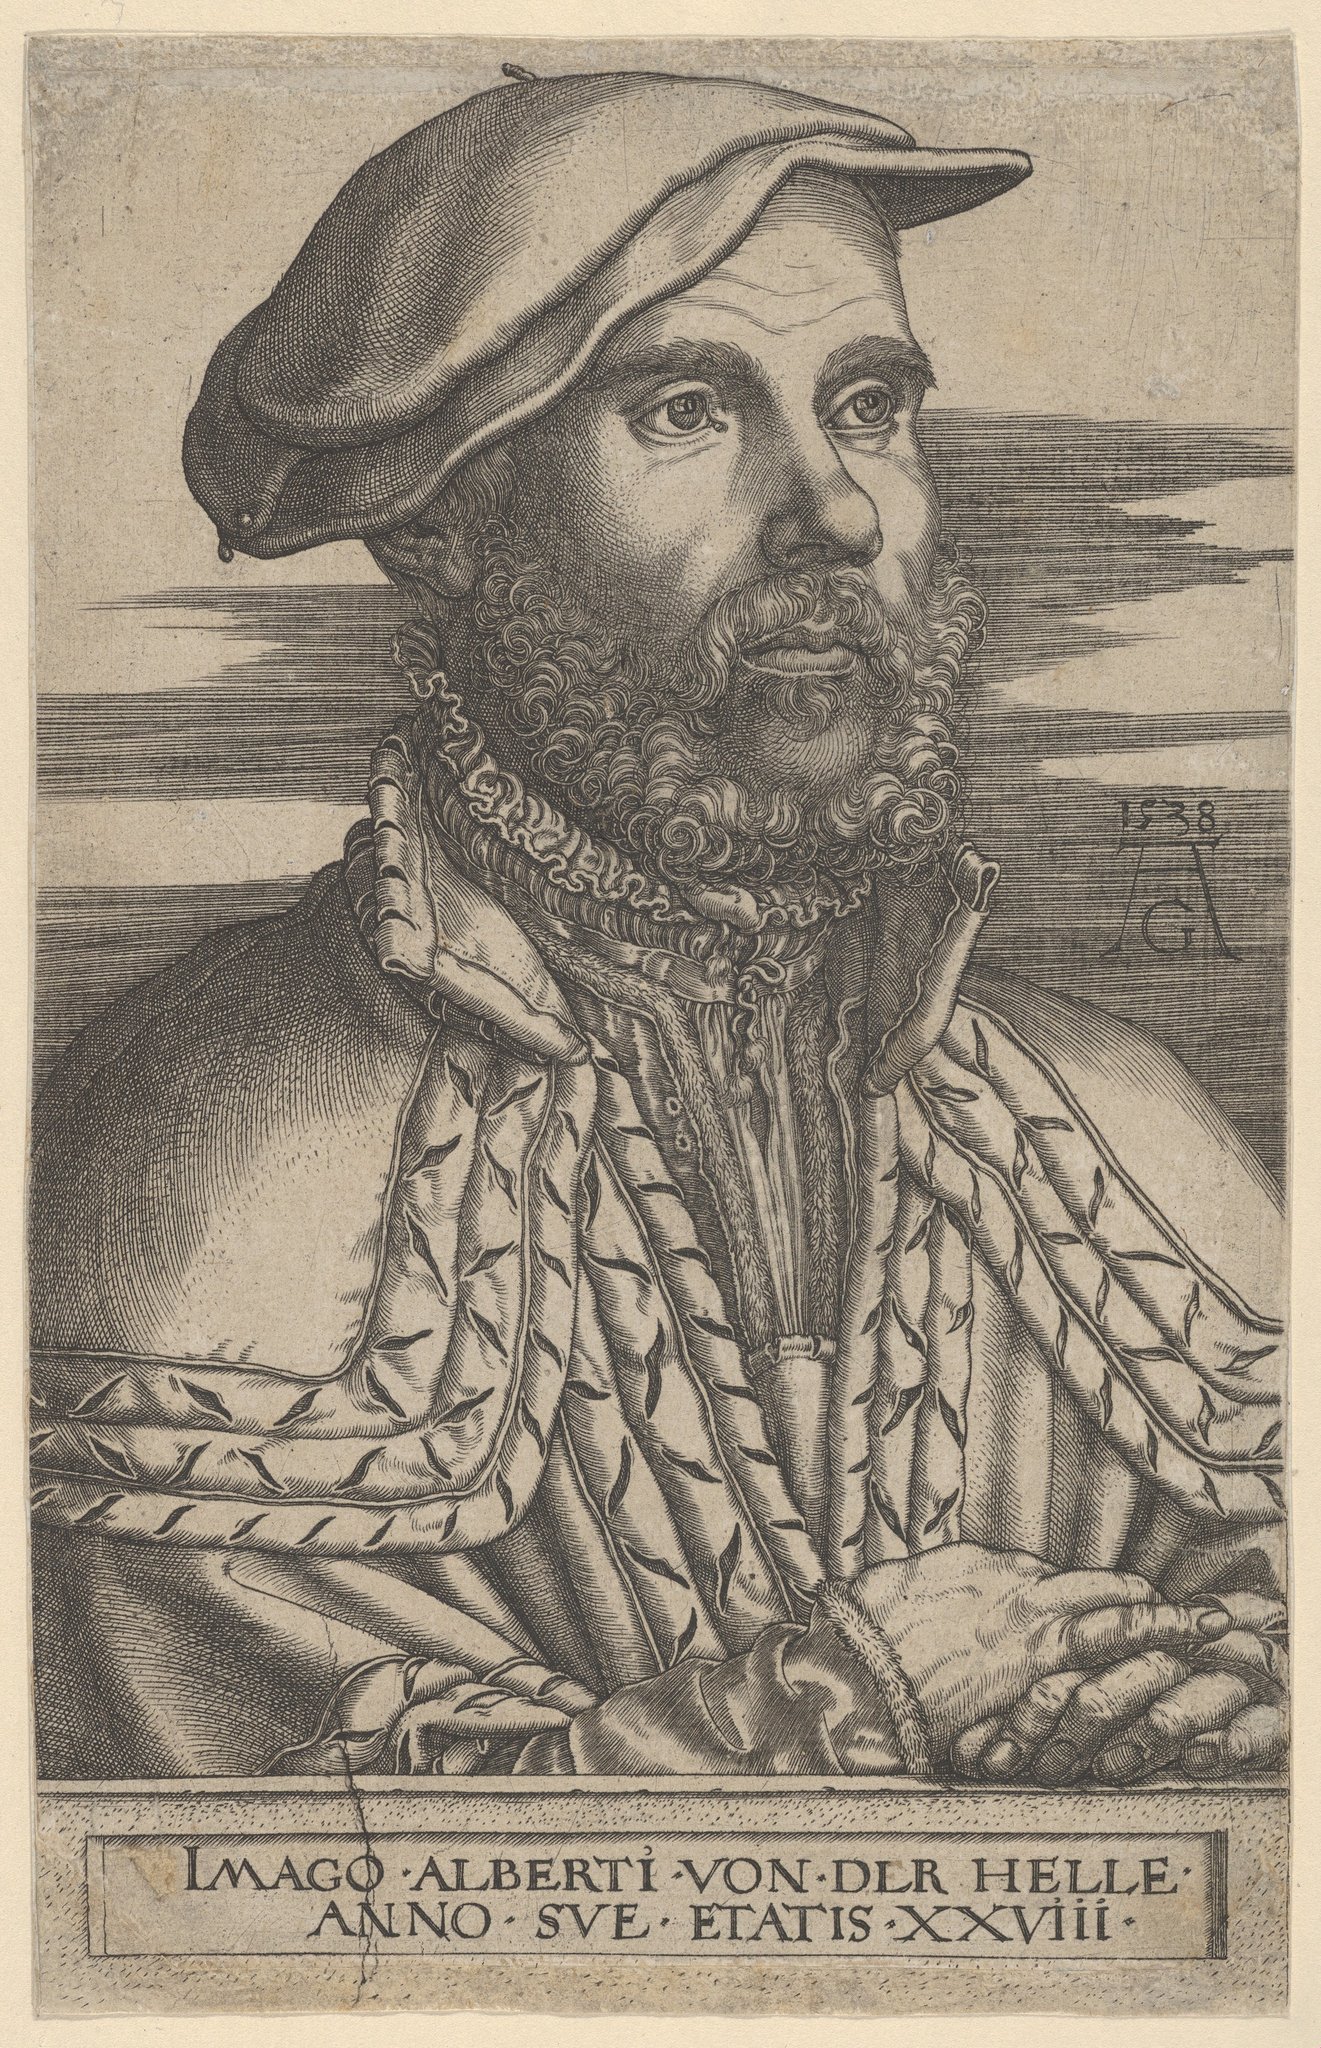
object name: print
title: Albert van der Helle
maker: heinrich aldegrever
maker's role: artist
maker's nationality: german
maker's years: 1502-1561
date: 1538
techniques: engraving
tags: men,portraits